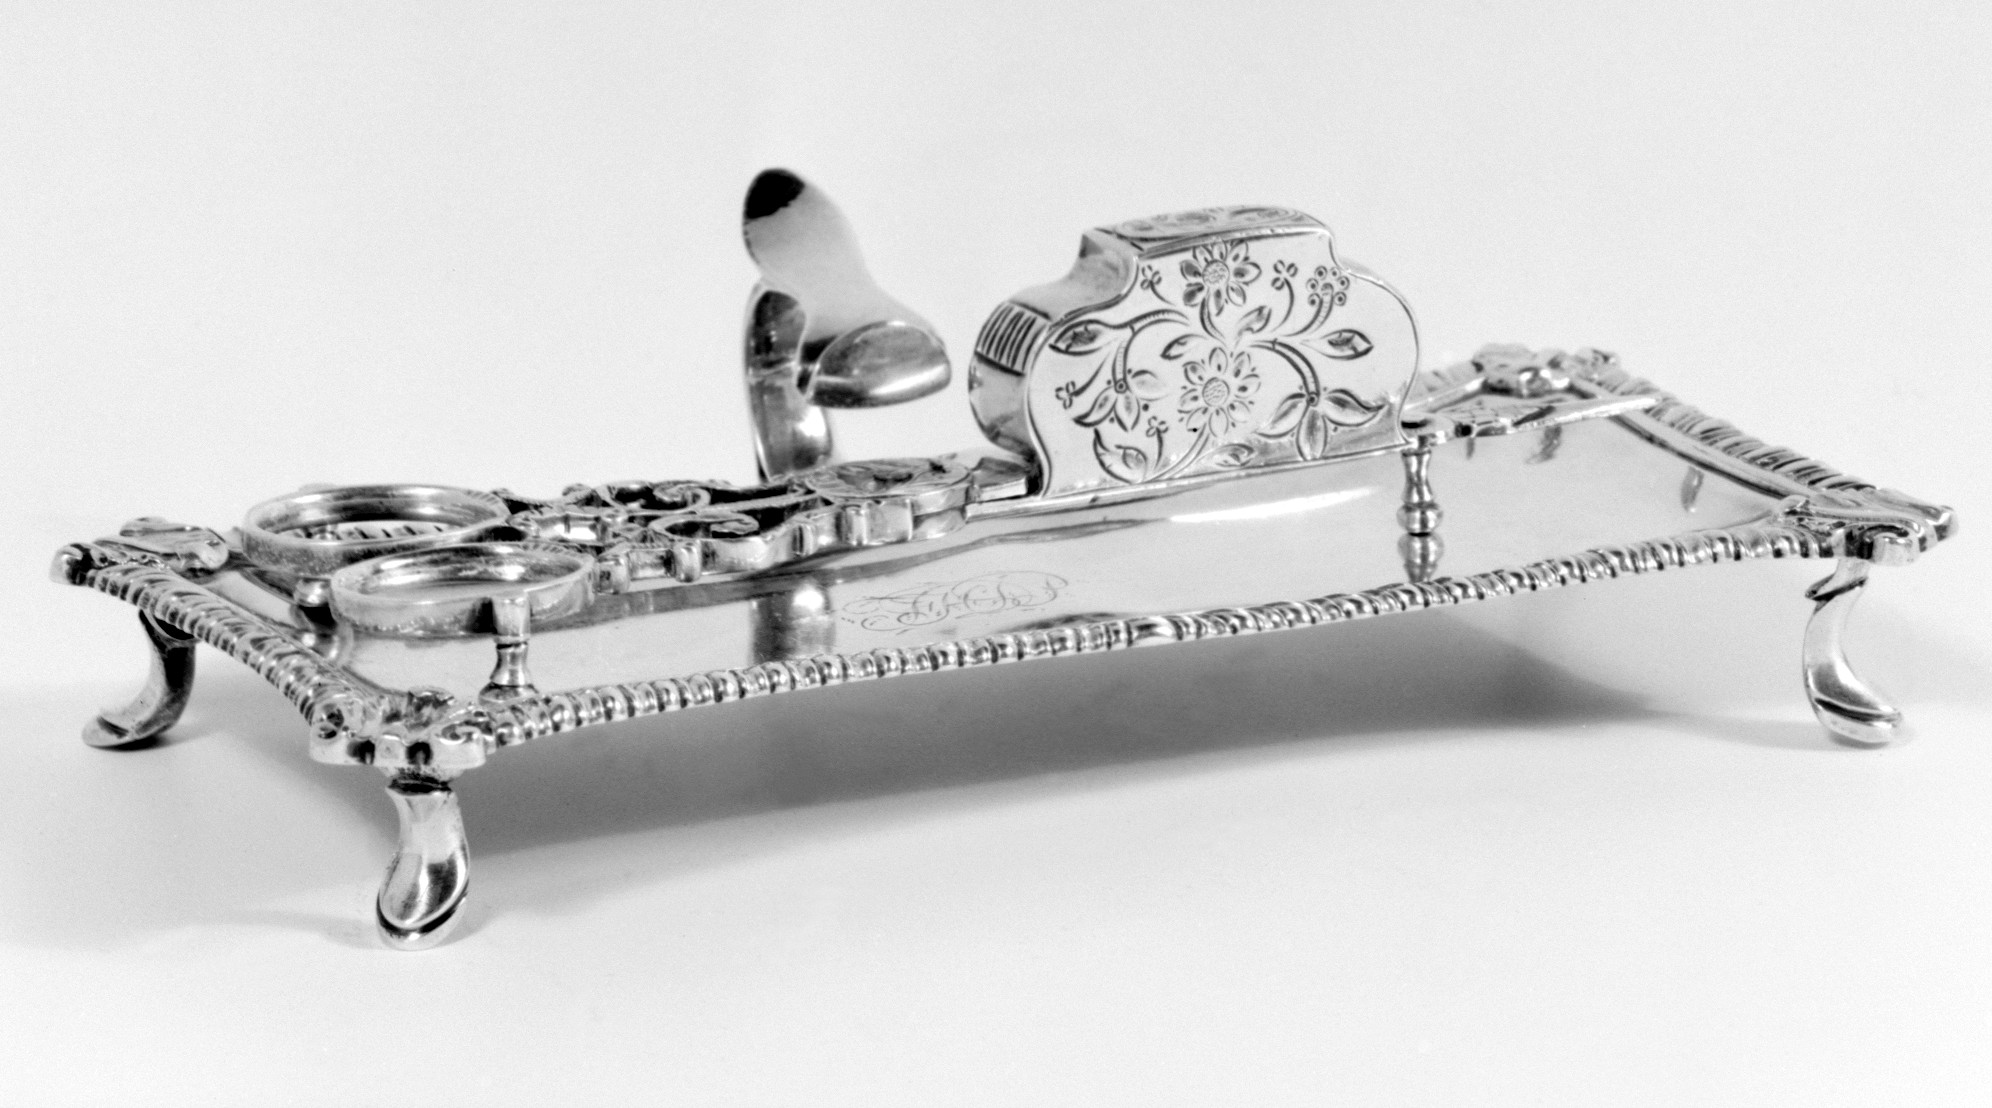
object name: snuffer tray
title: Snuffers tray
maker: w. t., london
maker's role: maker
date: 1765-1766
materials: silver